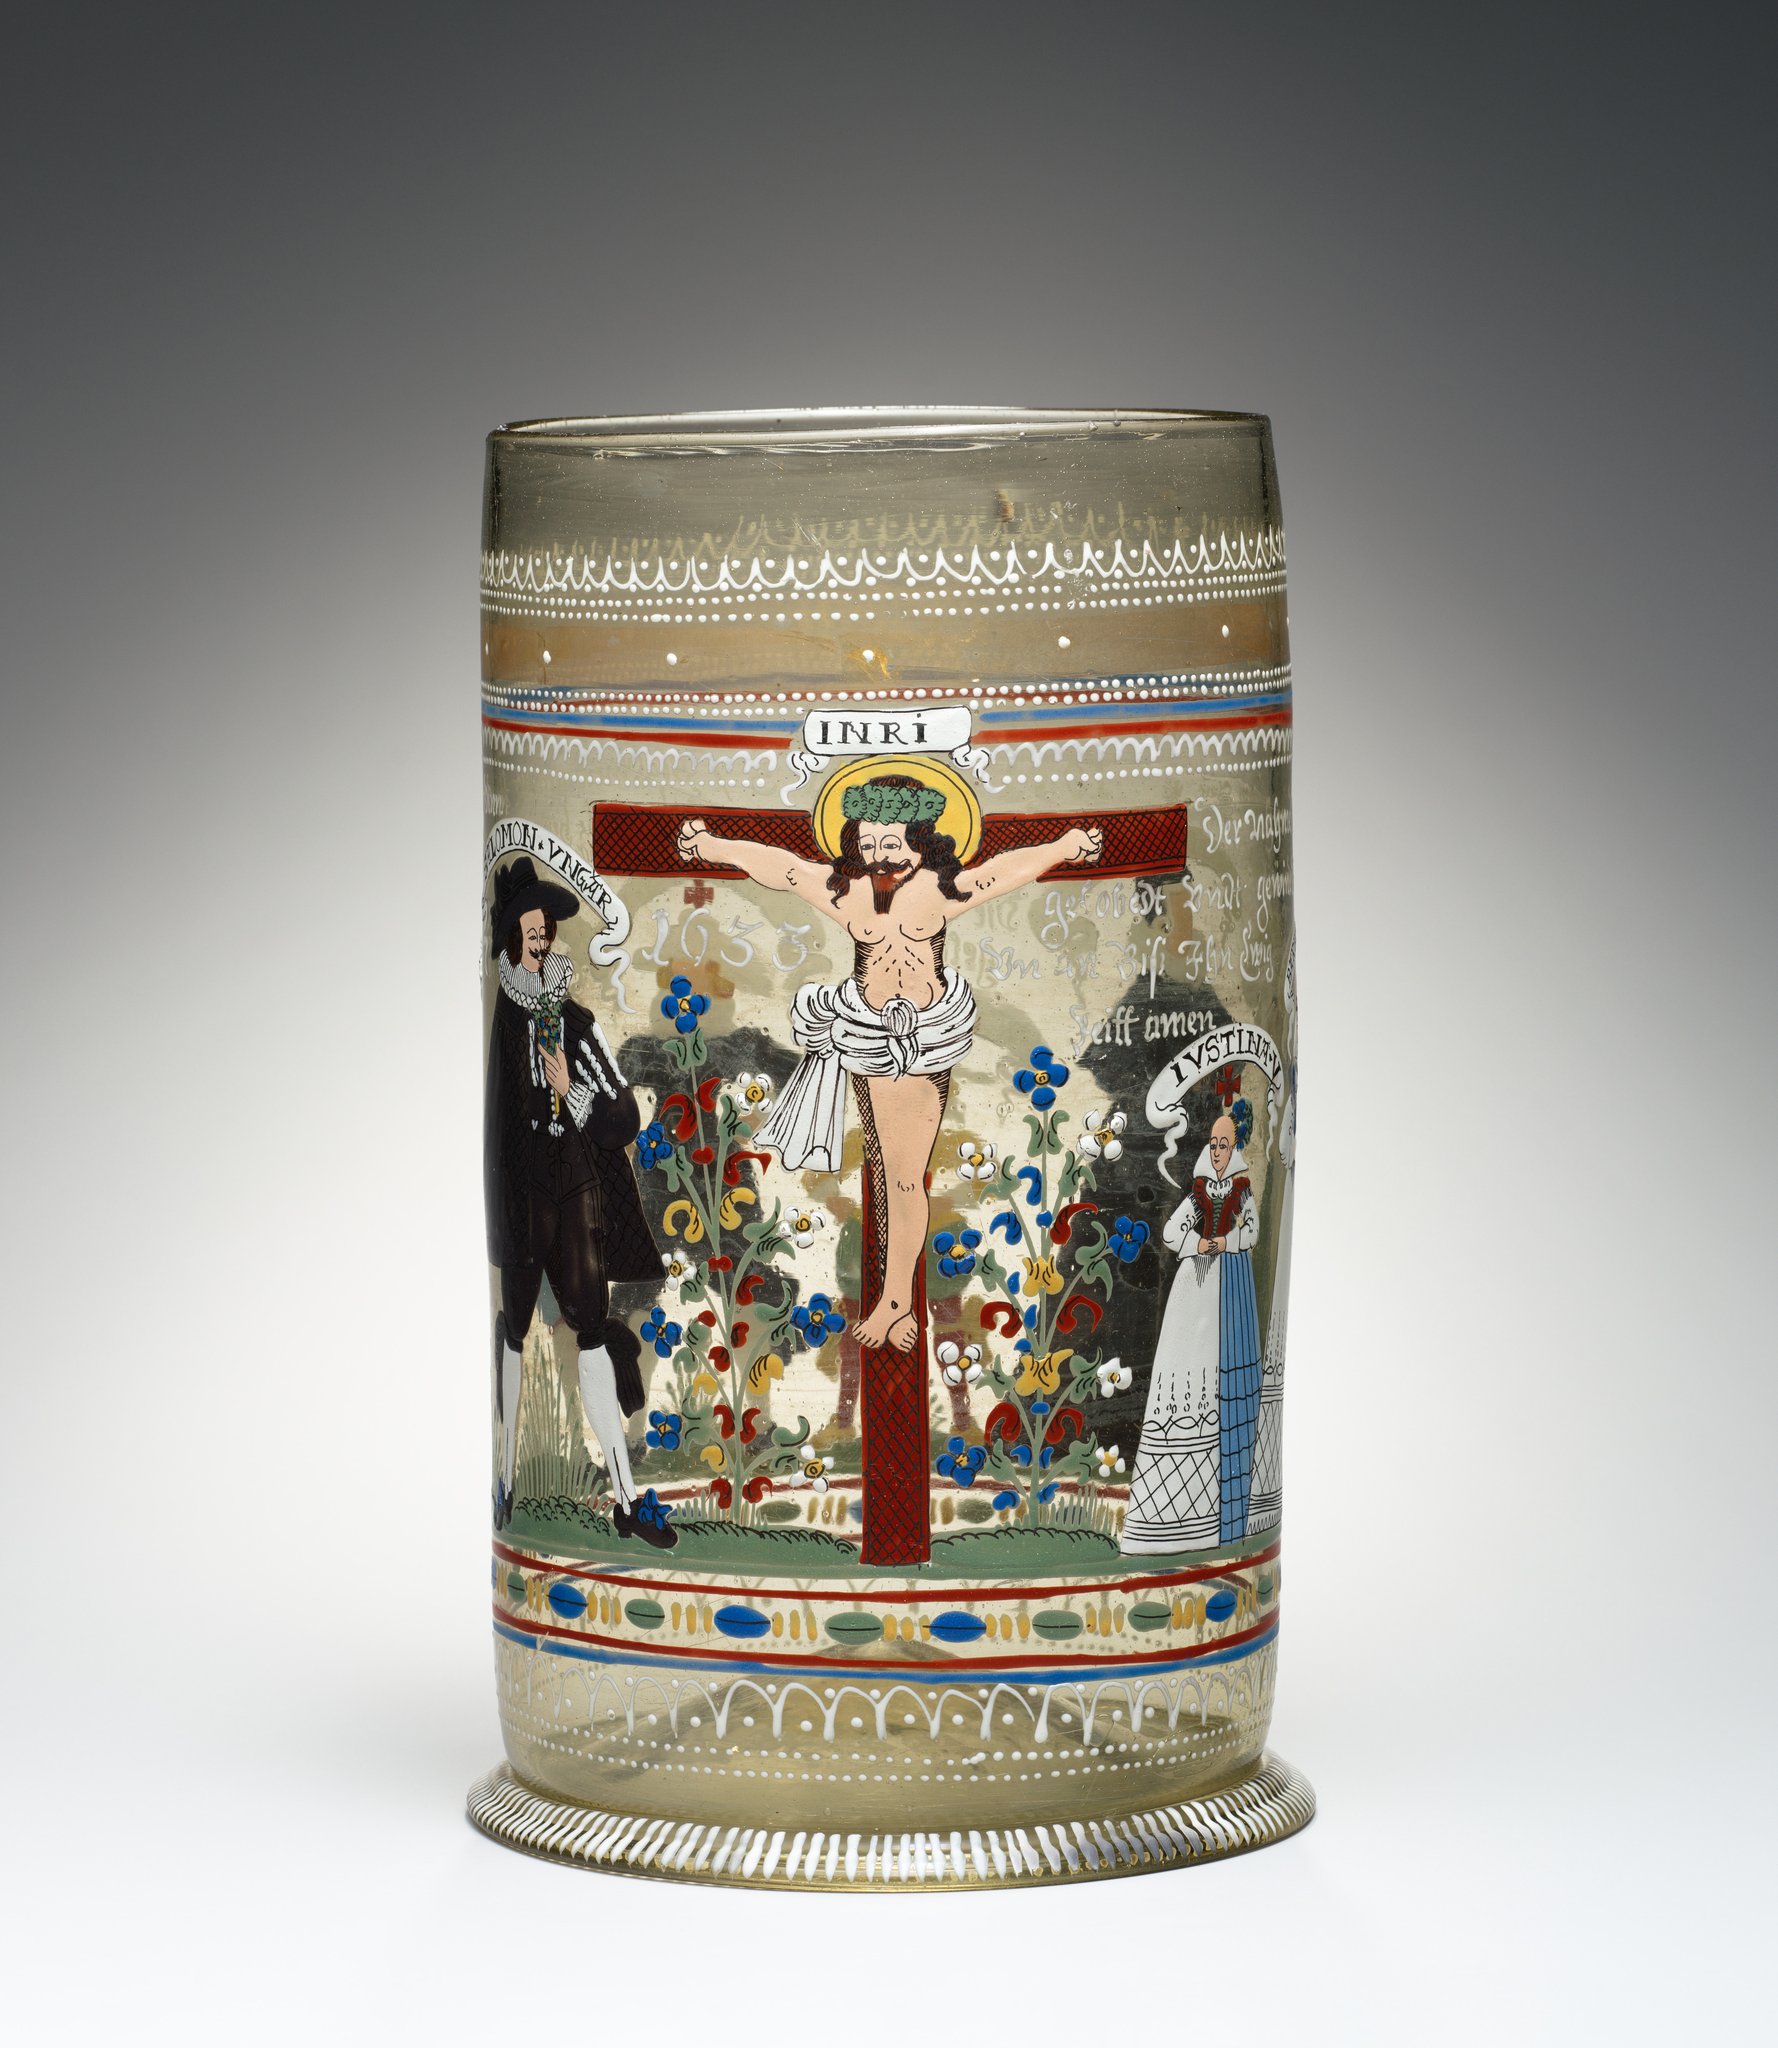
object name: beaker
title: Beaker (Humpen)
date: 1633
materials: glass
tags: men,christ